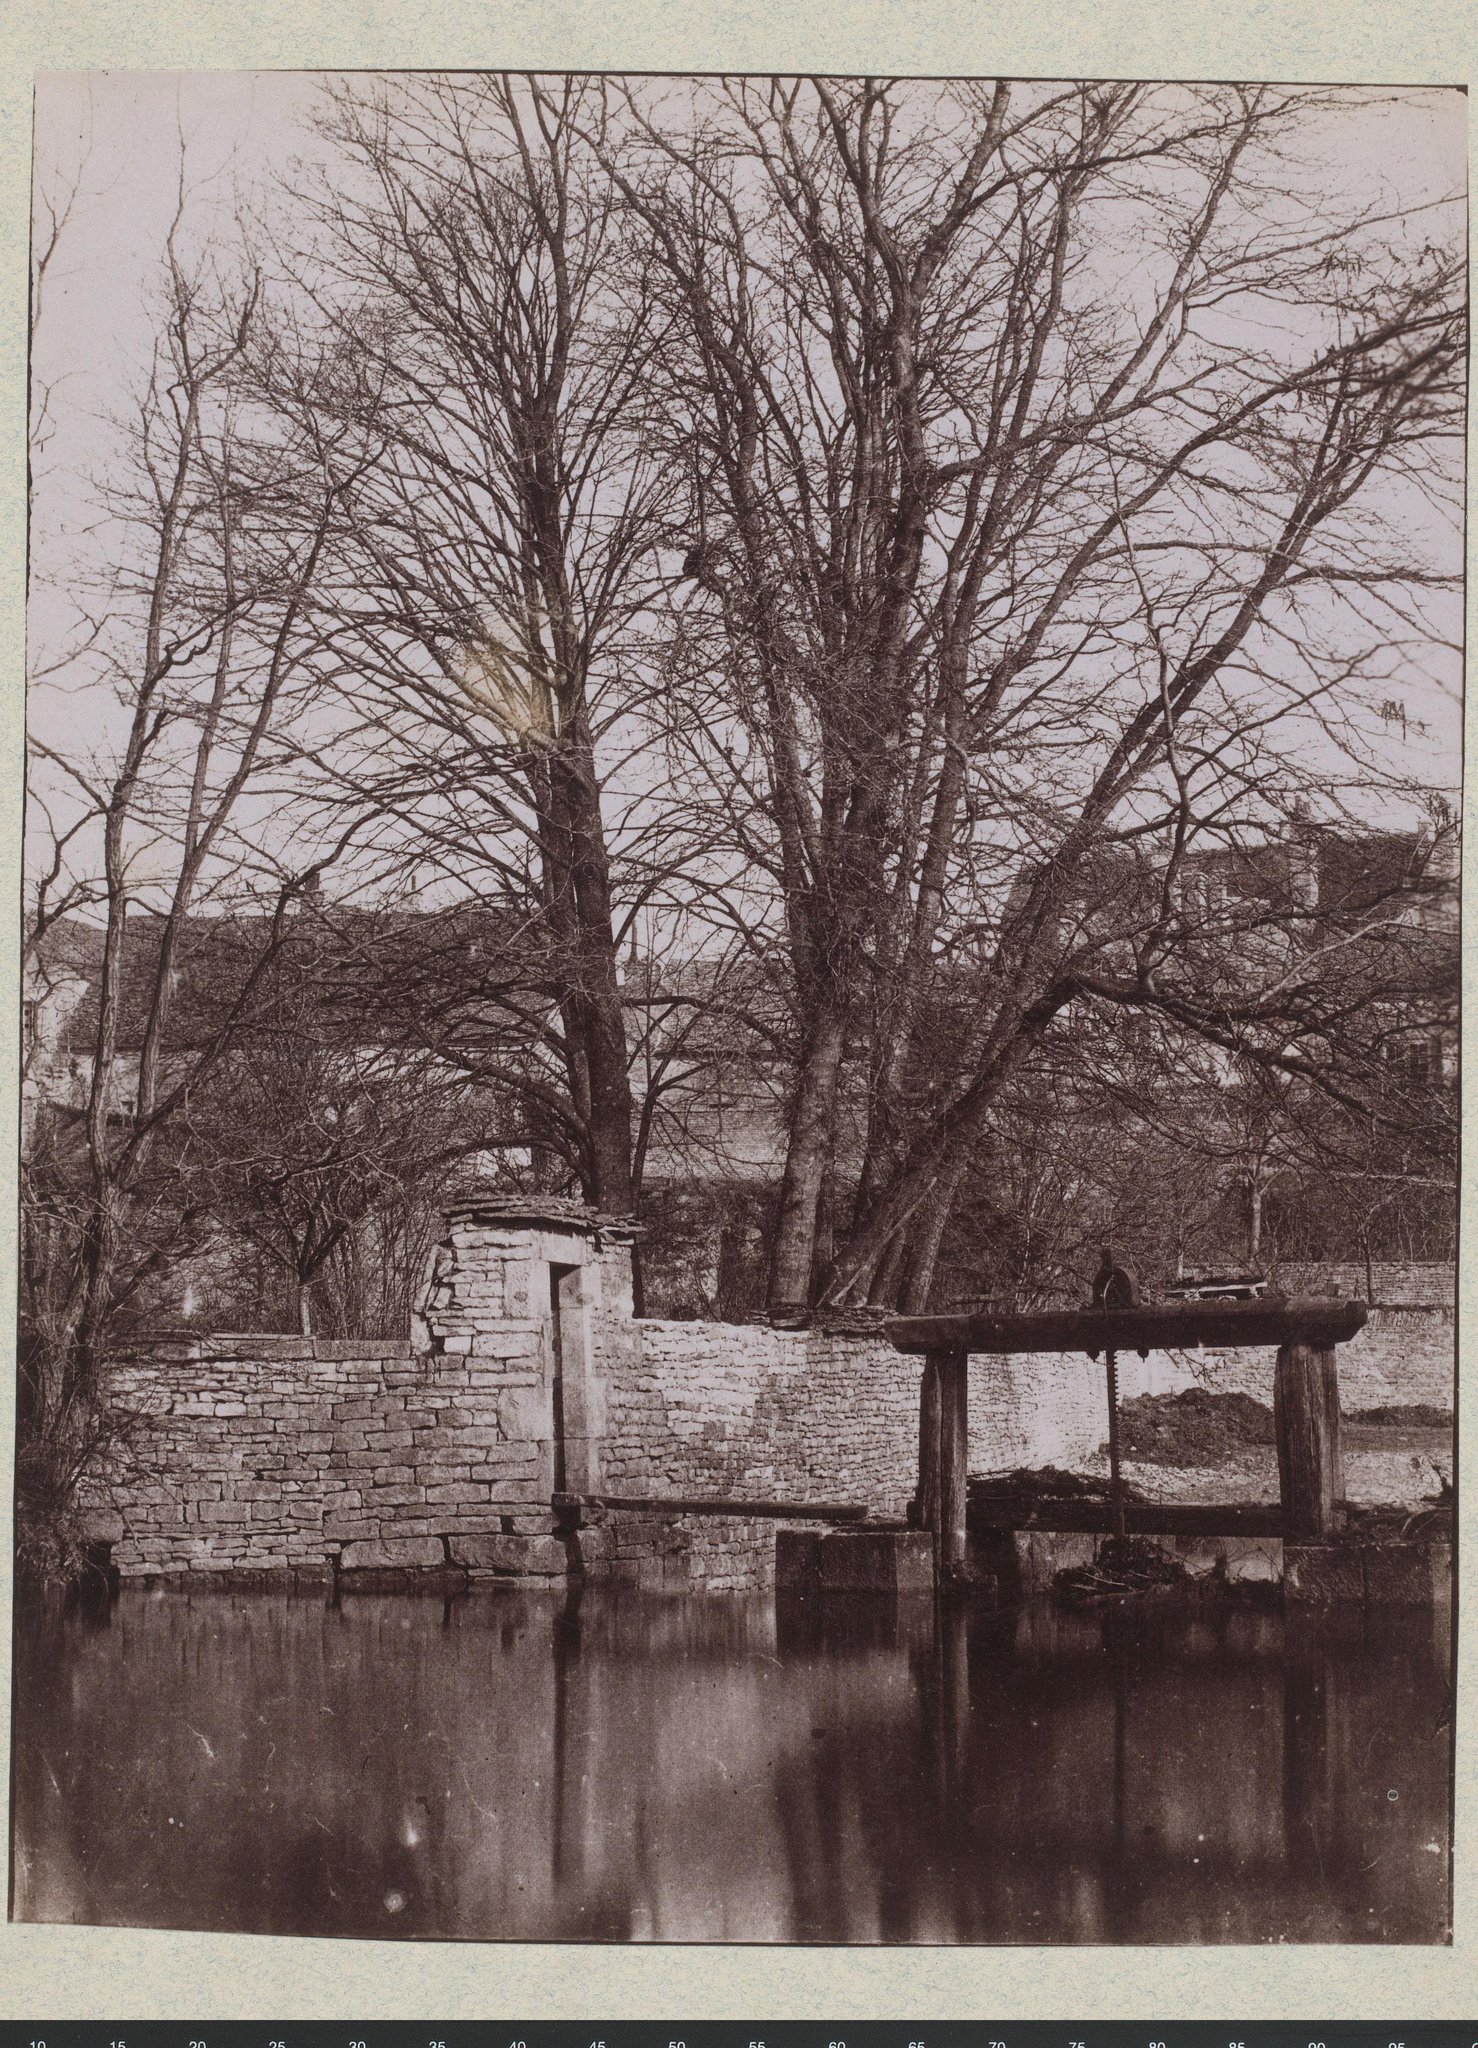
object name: photograph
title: Gezicht op een sluis in een rivier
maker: Anonymous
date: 1851-1900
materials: paper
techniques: albumen print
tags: sluice, weir